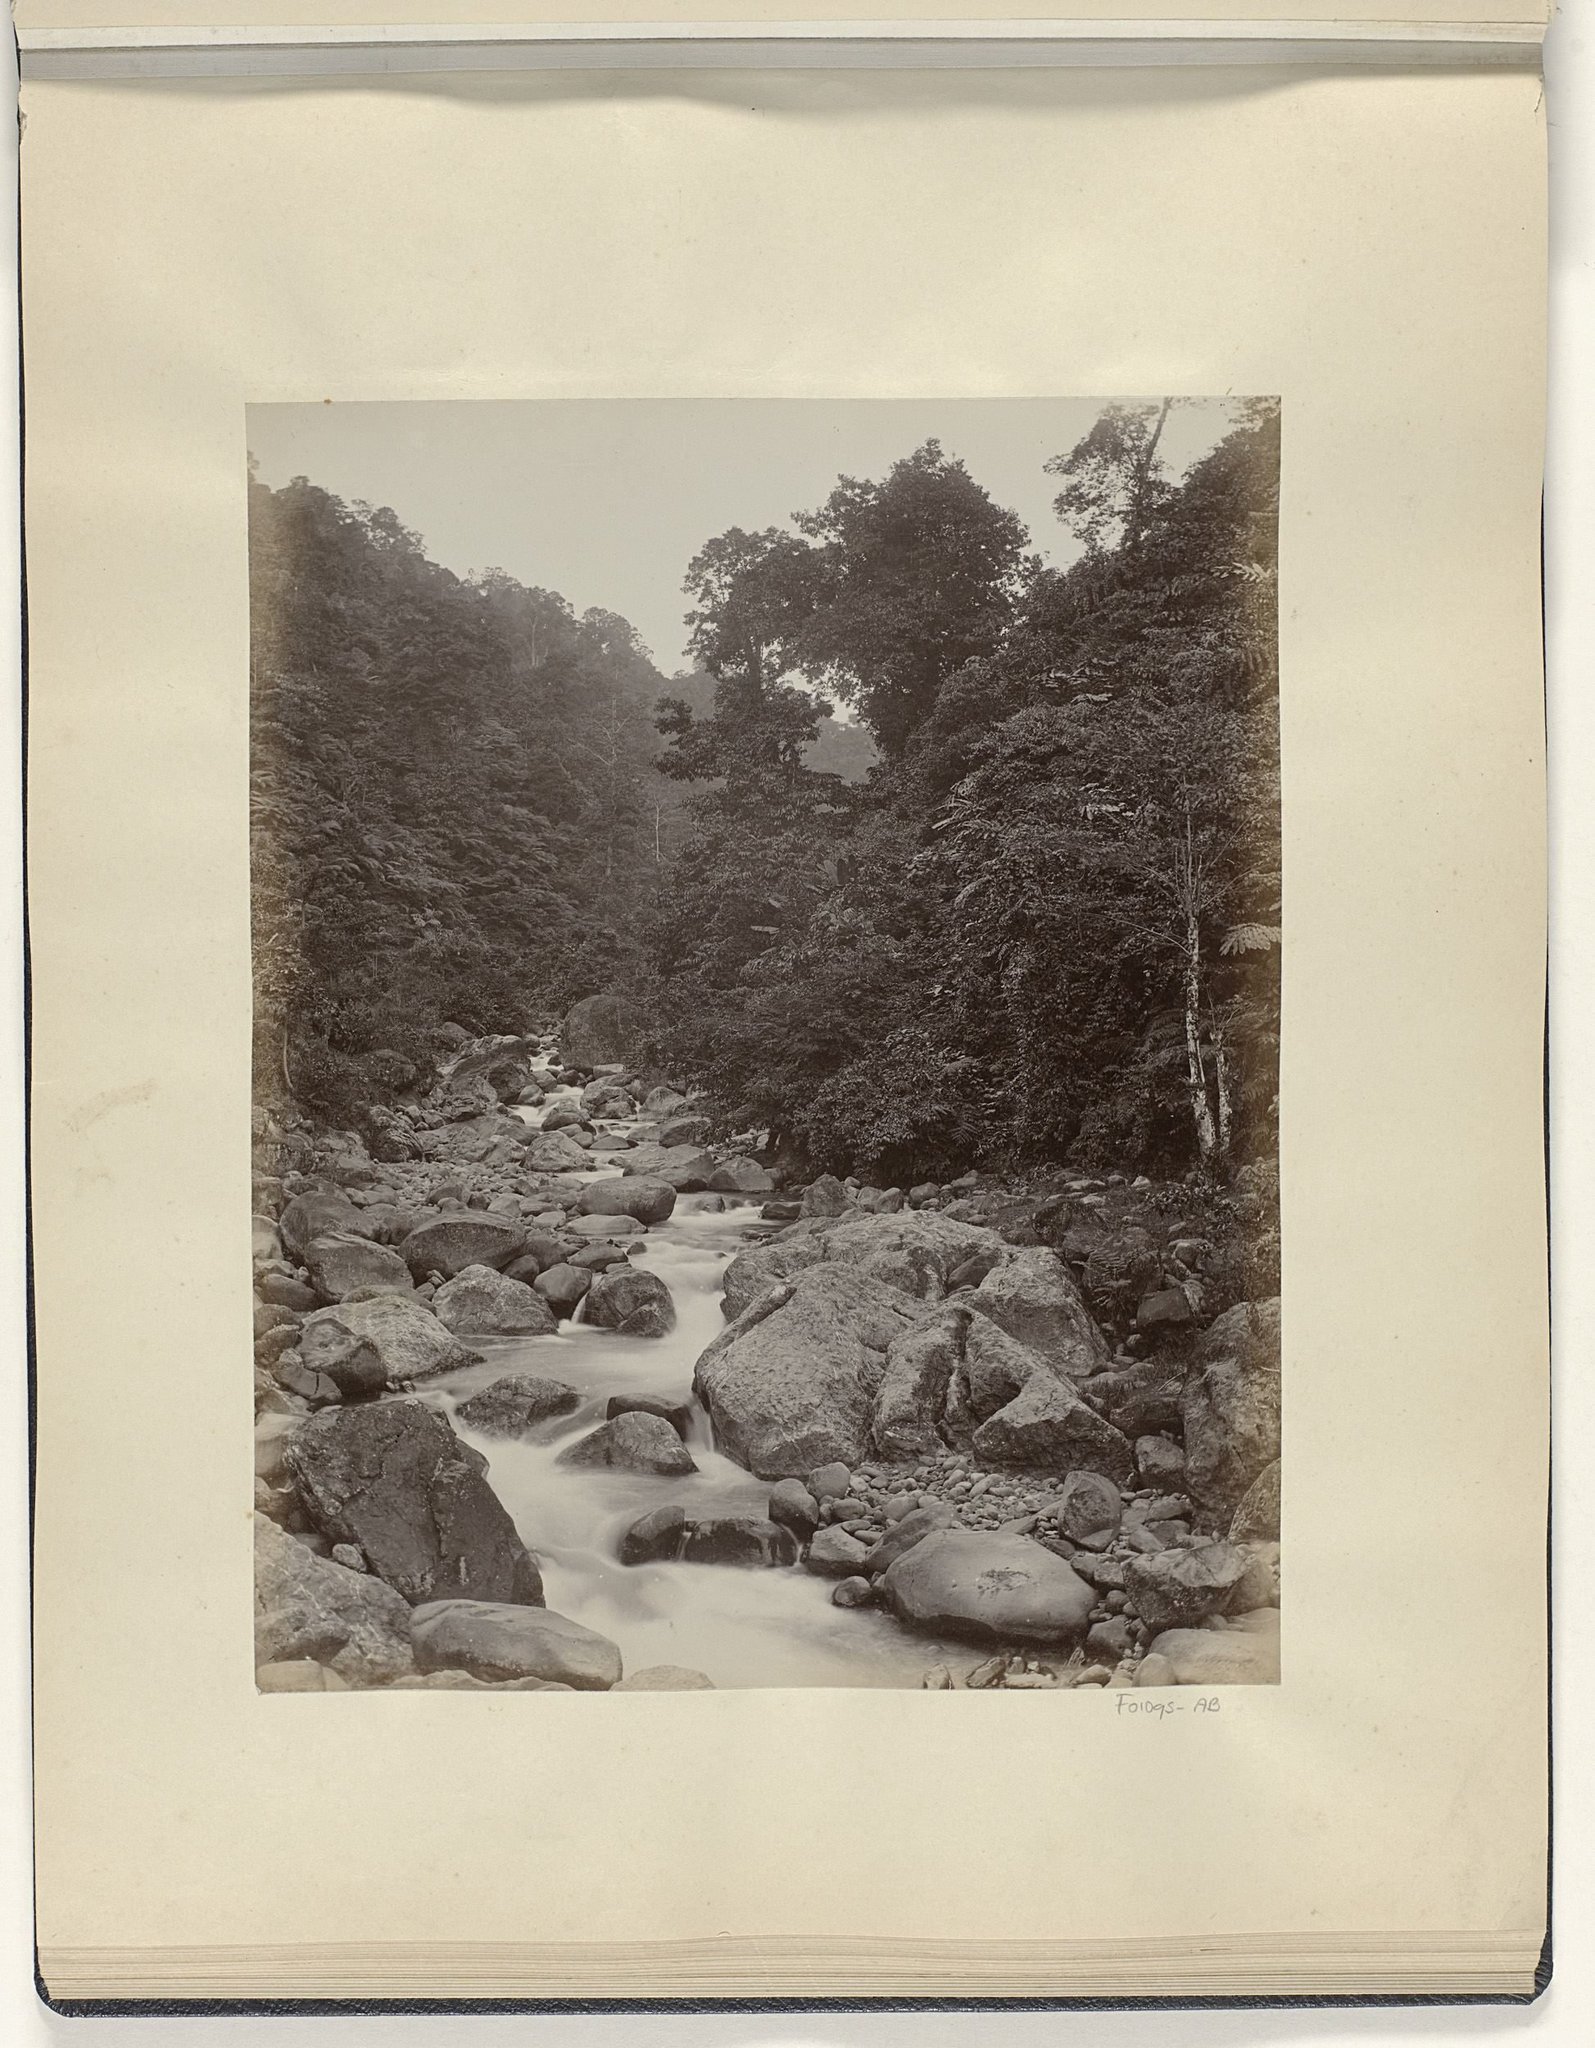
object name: photograph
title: Beek met rotsblokken in Nederlands-Indië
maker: Anonymous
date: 1895-1905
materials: paper, photographic support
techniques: albumen print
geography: dutch east indies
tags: brook, boulder, stone, dutch east indies, the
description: Onderdeel van Reisalbum met foto's van bezienswaardigheden in Italië, Zwitserland en Nederlands-Indië.